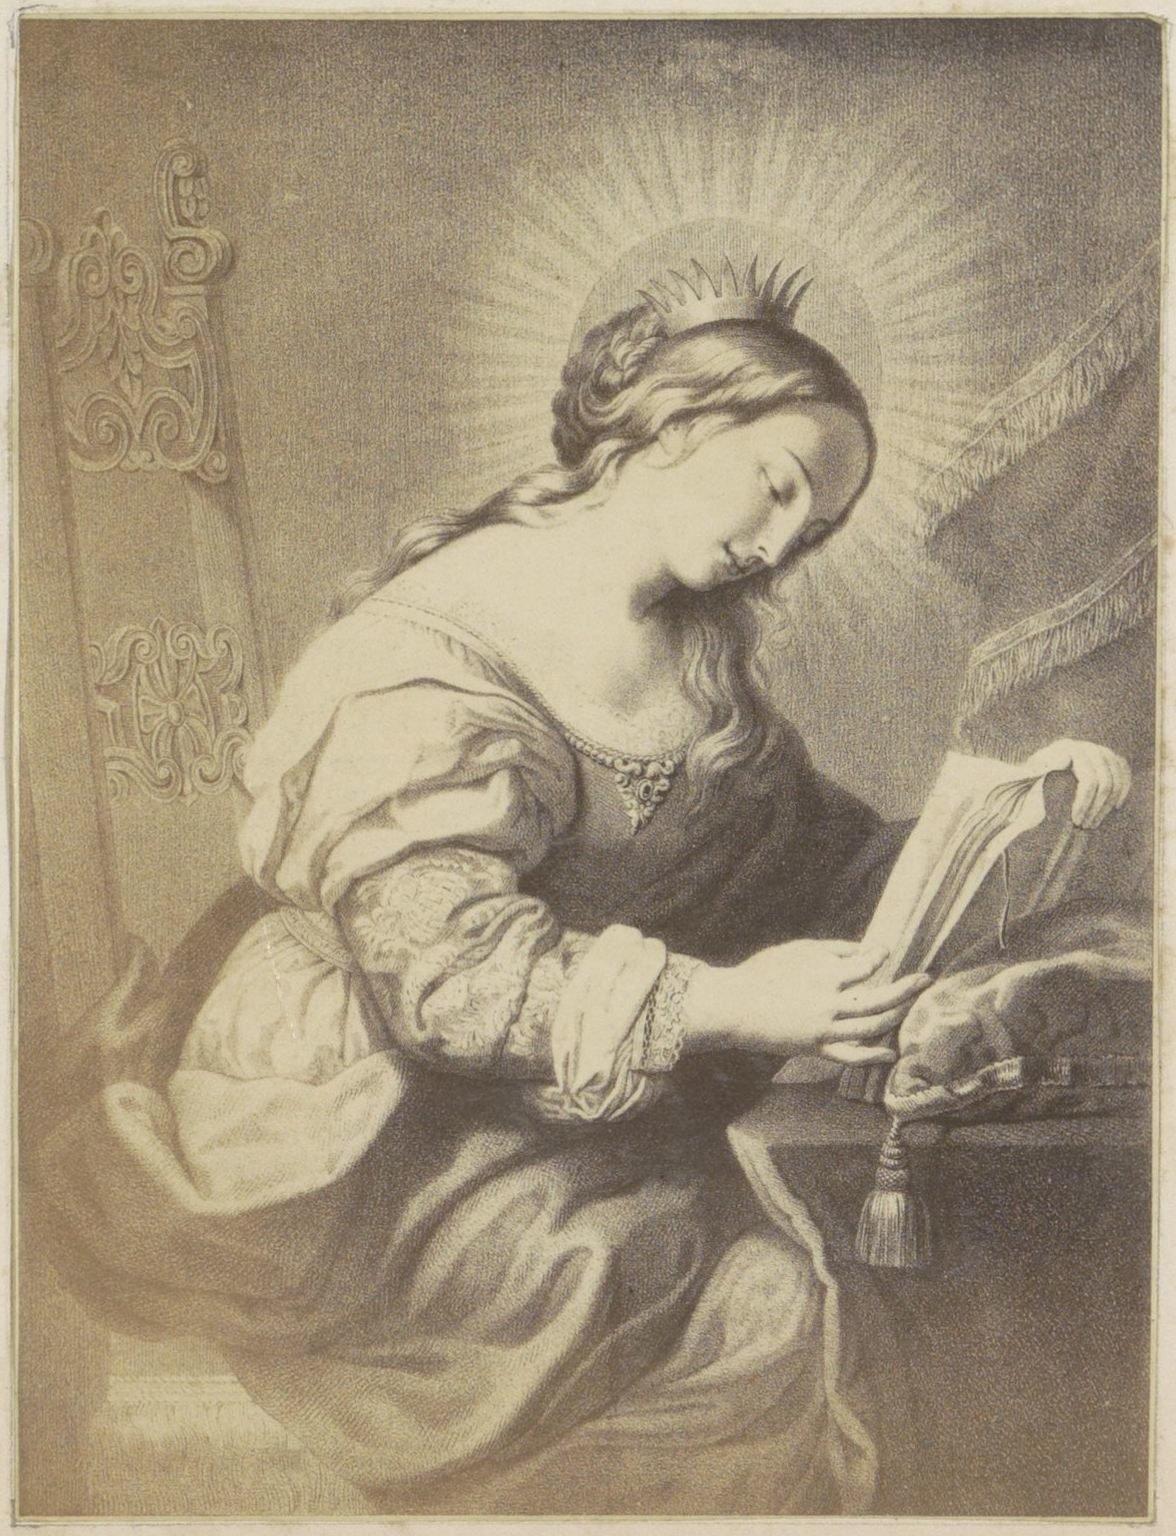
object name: reproduction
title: Fotoreproductie van (vermoedelijk) een prent van een lezende heilige vrouw met kroon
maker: Anonymous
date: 1850-1870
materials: paper, photographic support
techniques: albumen print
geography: england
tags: female saints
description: Onderdeel van Album met foto's van bezienswaardigheden en landschappen in Engeland en van kunst.